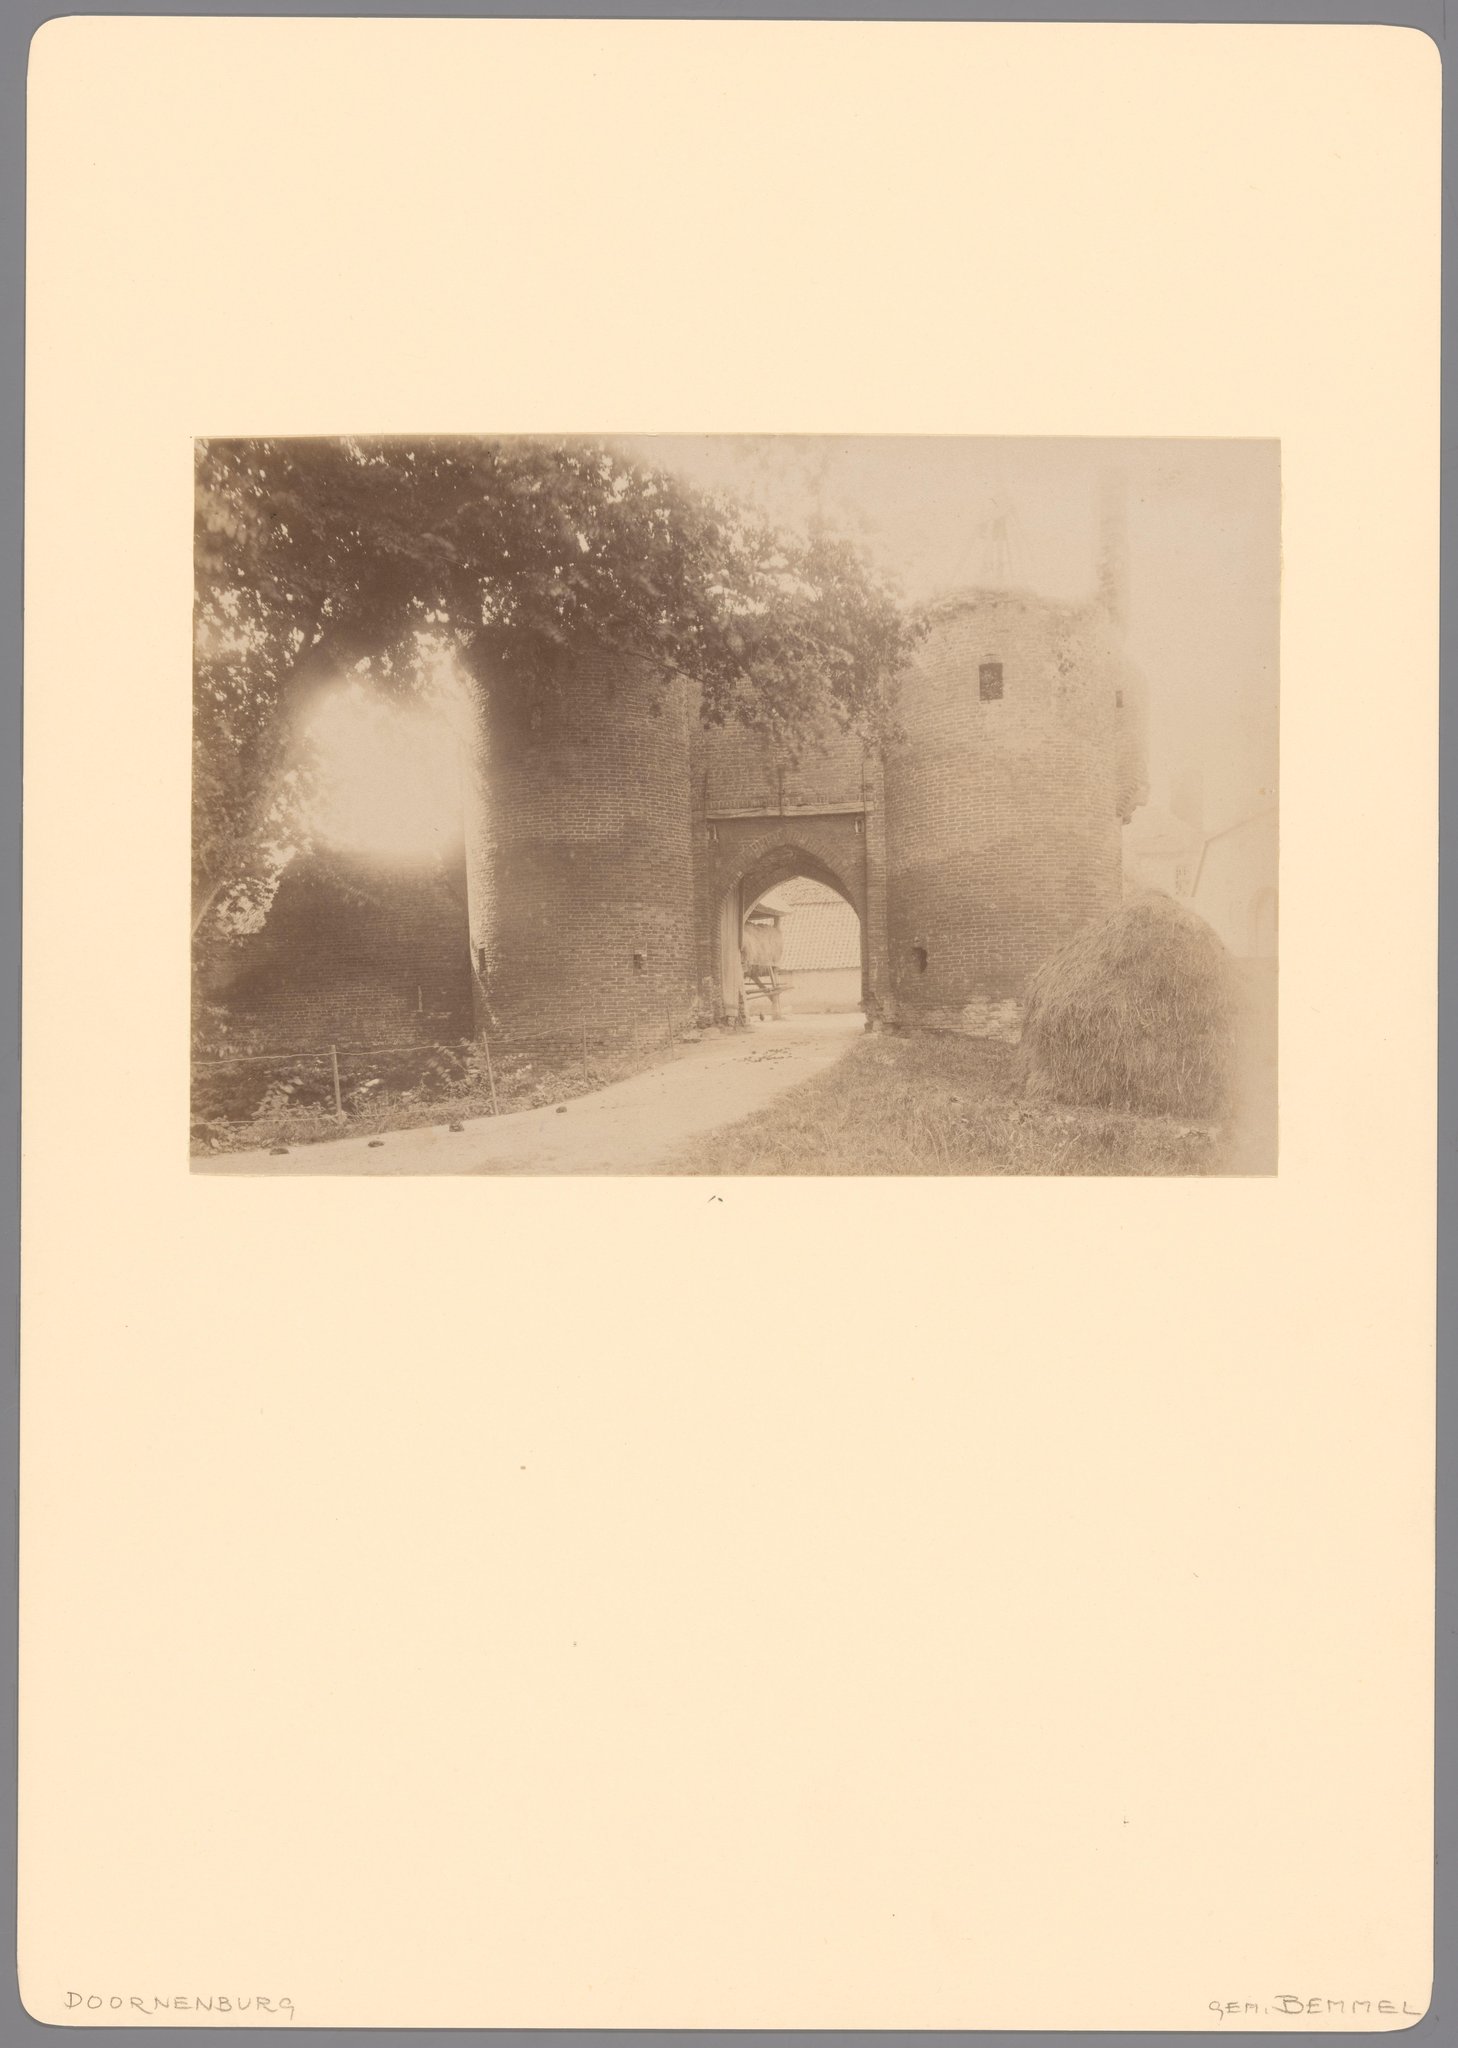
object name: photograph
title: Poort van Kasteel Doornenburg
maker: anoniem (monumentenzorg)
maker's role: fotograaf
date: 1903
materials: cardboard, photographic support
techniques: albumen print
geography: doornenburg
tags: gate, entrance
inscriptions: annotation: ‘Kasteel Doornenburg (G.)/ Poort v/d voorhof’, annotation: ‘Doornenburg/ gem. Bemmel’